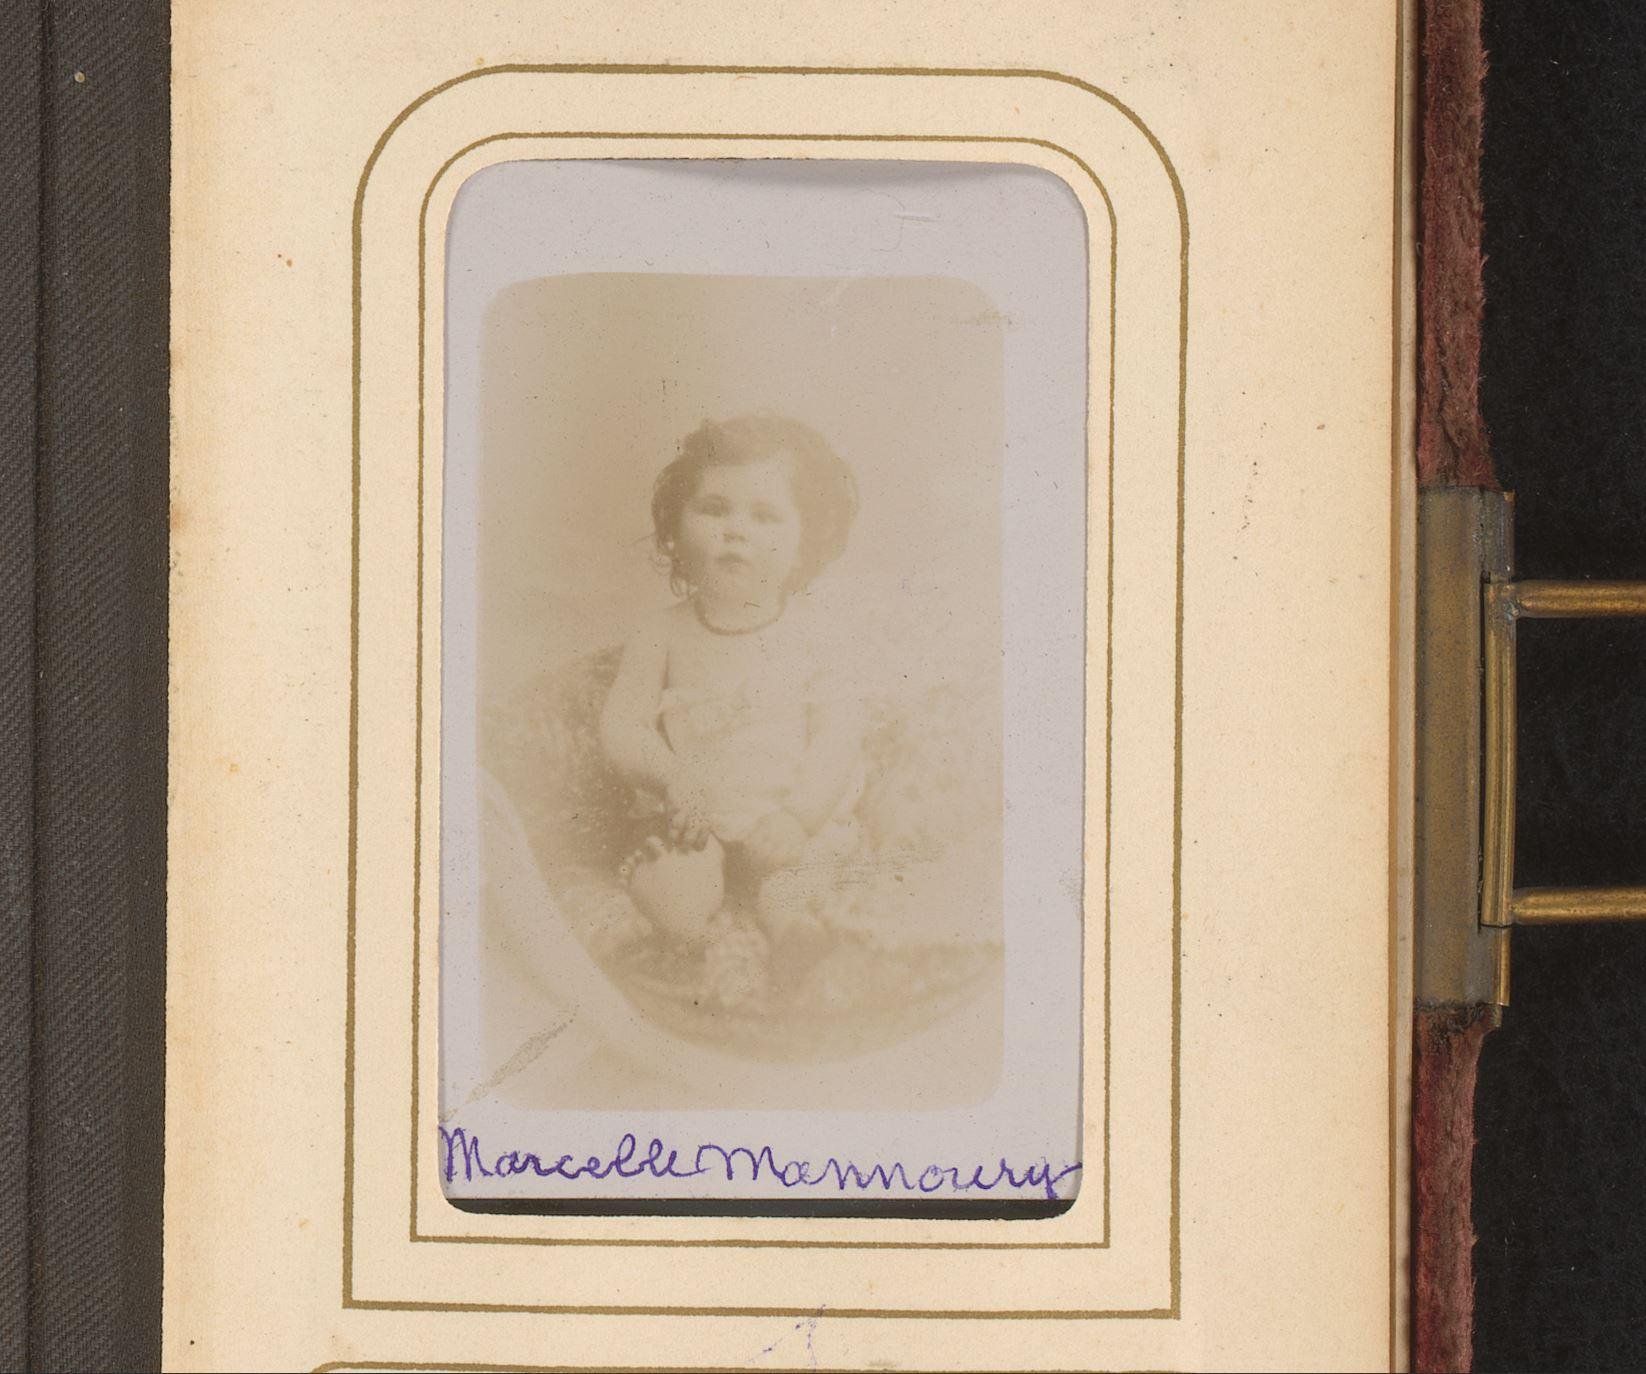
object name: album leaf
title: Portret van een kind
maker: Anonymous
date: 1880-1920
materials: cardboard, photographic support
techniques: daylight paper print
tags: child, historical persons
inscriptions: annotation: ‘Marcell [..]’